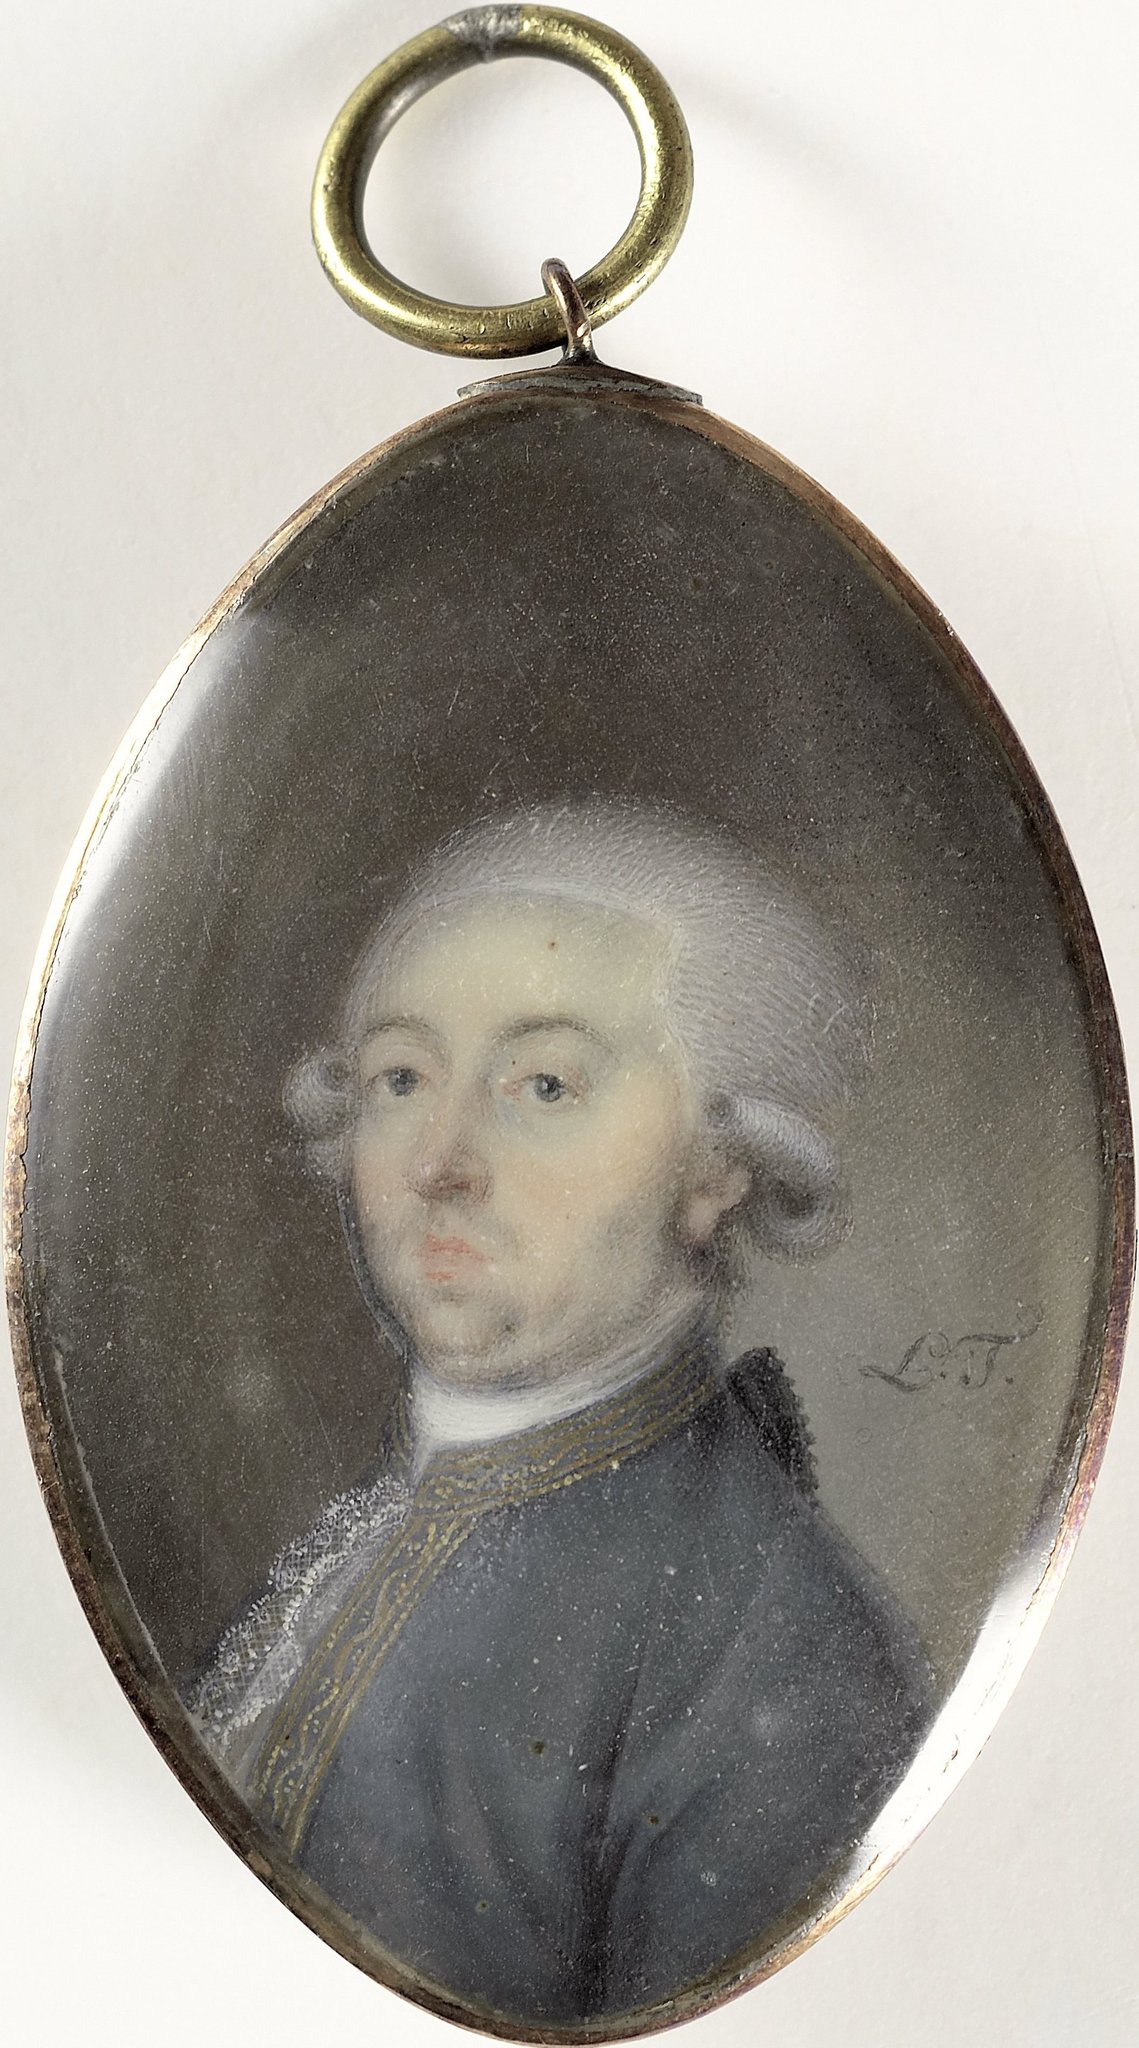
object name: painting, miniature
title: Rudolf van Olden (1746-1813). Raad- en rekenmeester van prins Willem V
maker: leonardus temminck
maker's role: print maker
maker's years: 1753-1813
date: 1780-1800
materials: glass, hair, ivory, metal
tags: william v (prince of orange)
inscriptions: signature: ‘LT’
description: Leonardus Temminck (1753 - 1813). Rudolf van Olden (1746 - 1813), Councillor and Treasurer, later Paymaster of Prince Willem V. Ivory.